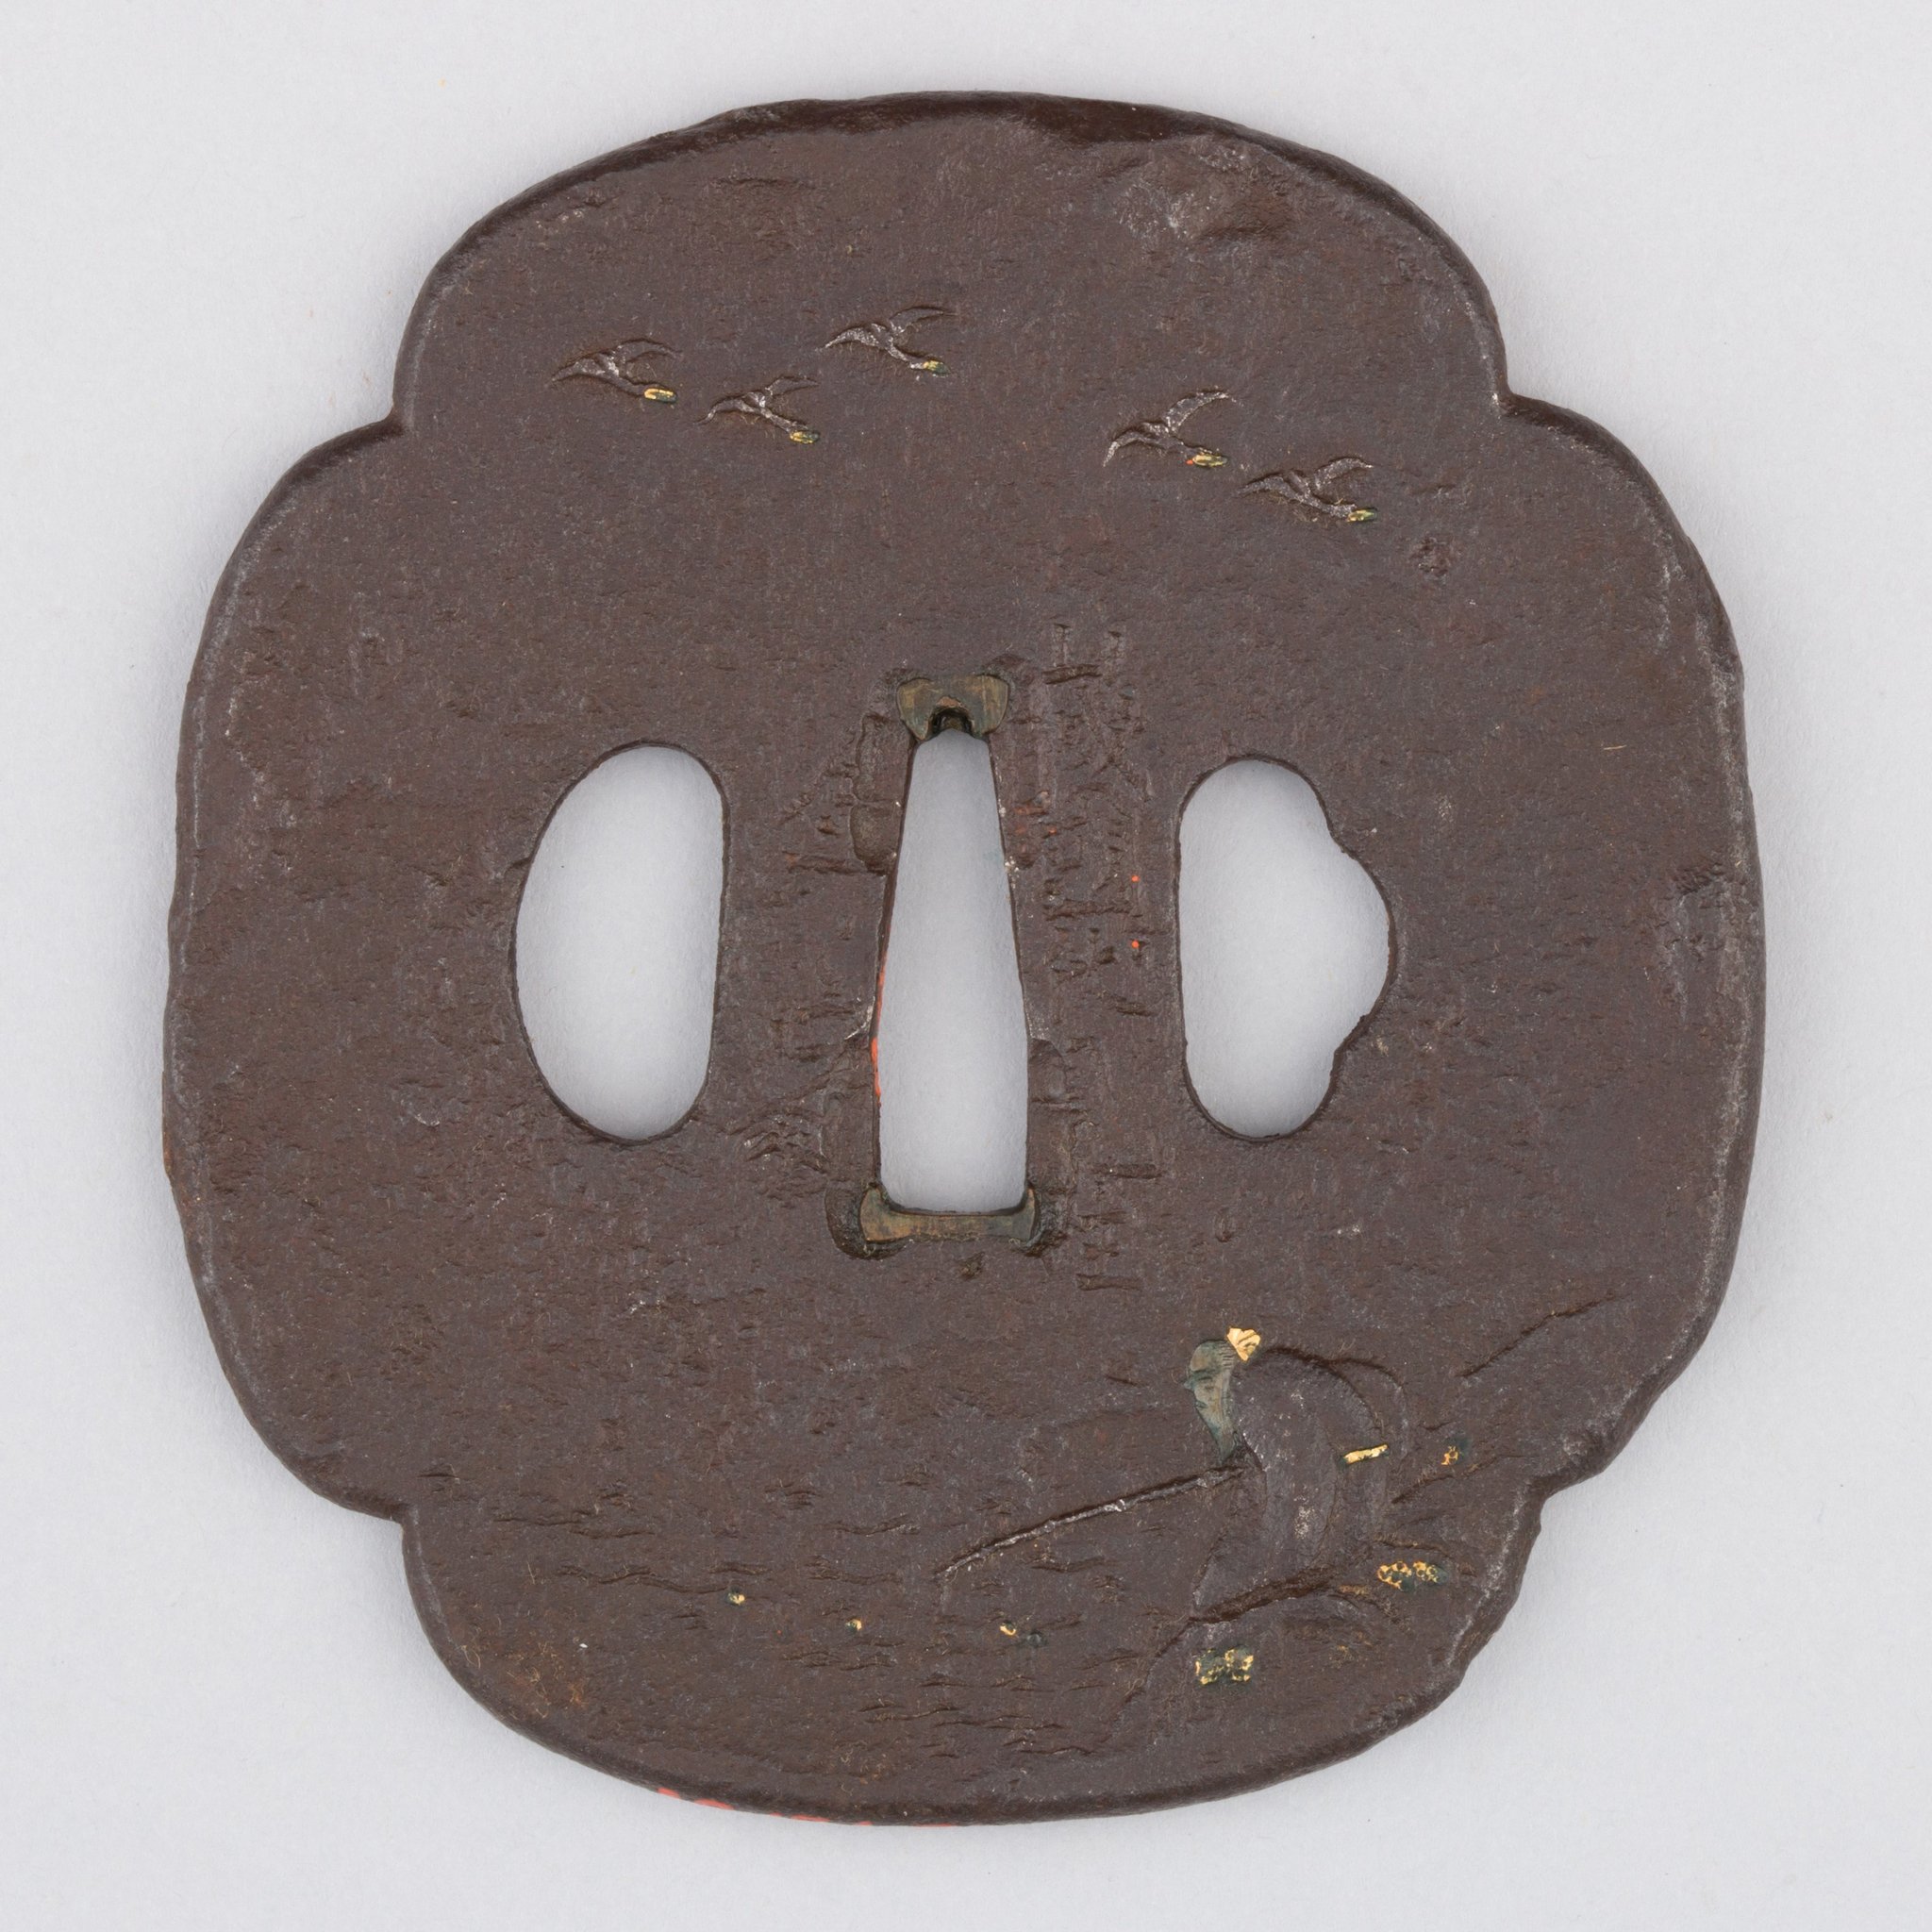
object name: sword guard tsuba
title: Sword Guard (Tsuba)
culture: japanese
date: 1615-1868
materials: copper, iron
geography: japan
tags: geese,men